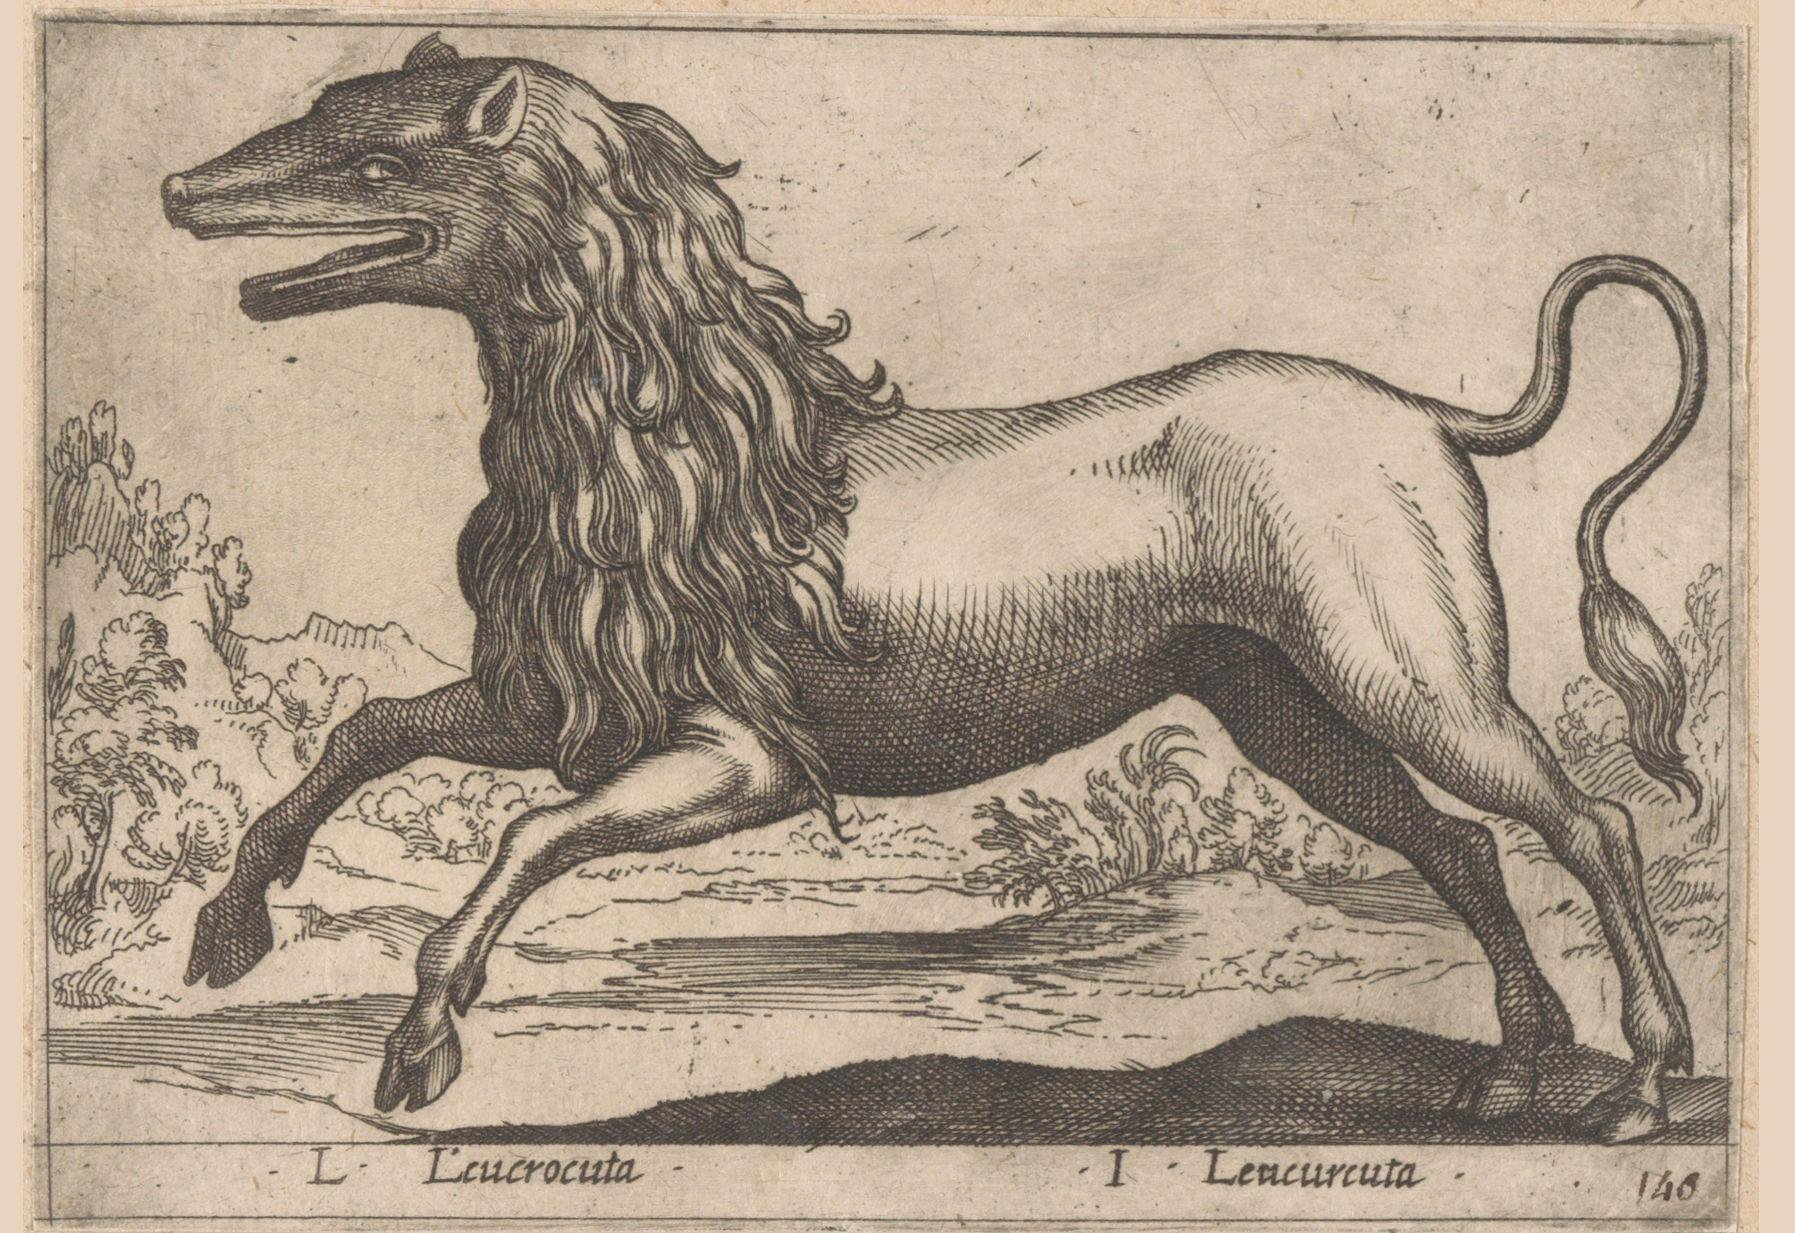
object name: print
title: Dieren en fabelwezens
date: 1565-1630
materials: paper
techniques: etching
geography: italy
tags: horse, mis-shapen animals; monsters, beasts of prey, predatory animals: lion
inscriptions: number: ‘148’, collector's mark: Lugt 11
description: Deze prent maakt deel uit van een reeks prenten van dieren door Antonio Tempesta. Bekend is dat een tweede staat (met nummering) van deze serie is uitgegeven door Giovanni Giacomo de' Rossi in 1650. Onbekend is wie de eerste staat heeft uitgegeven en wanneer.